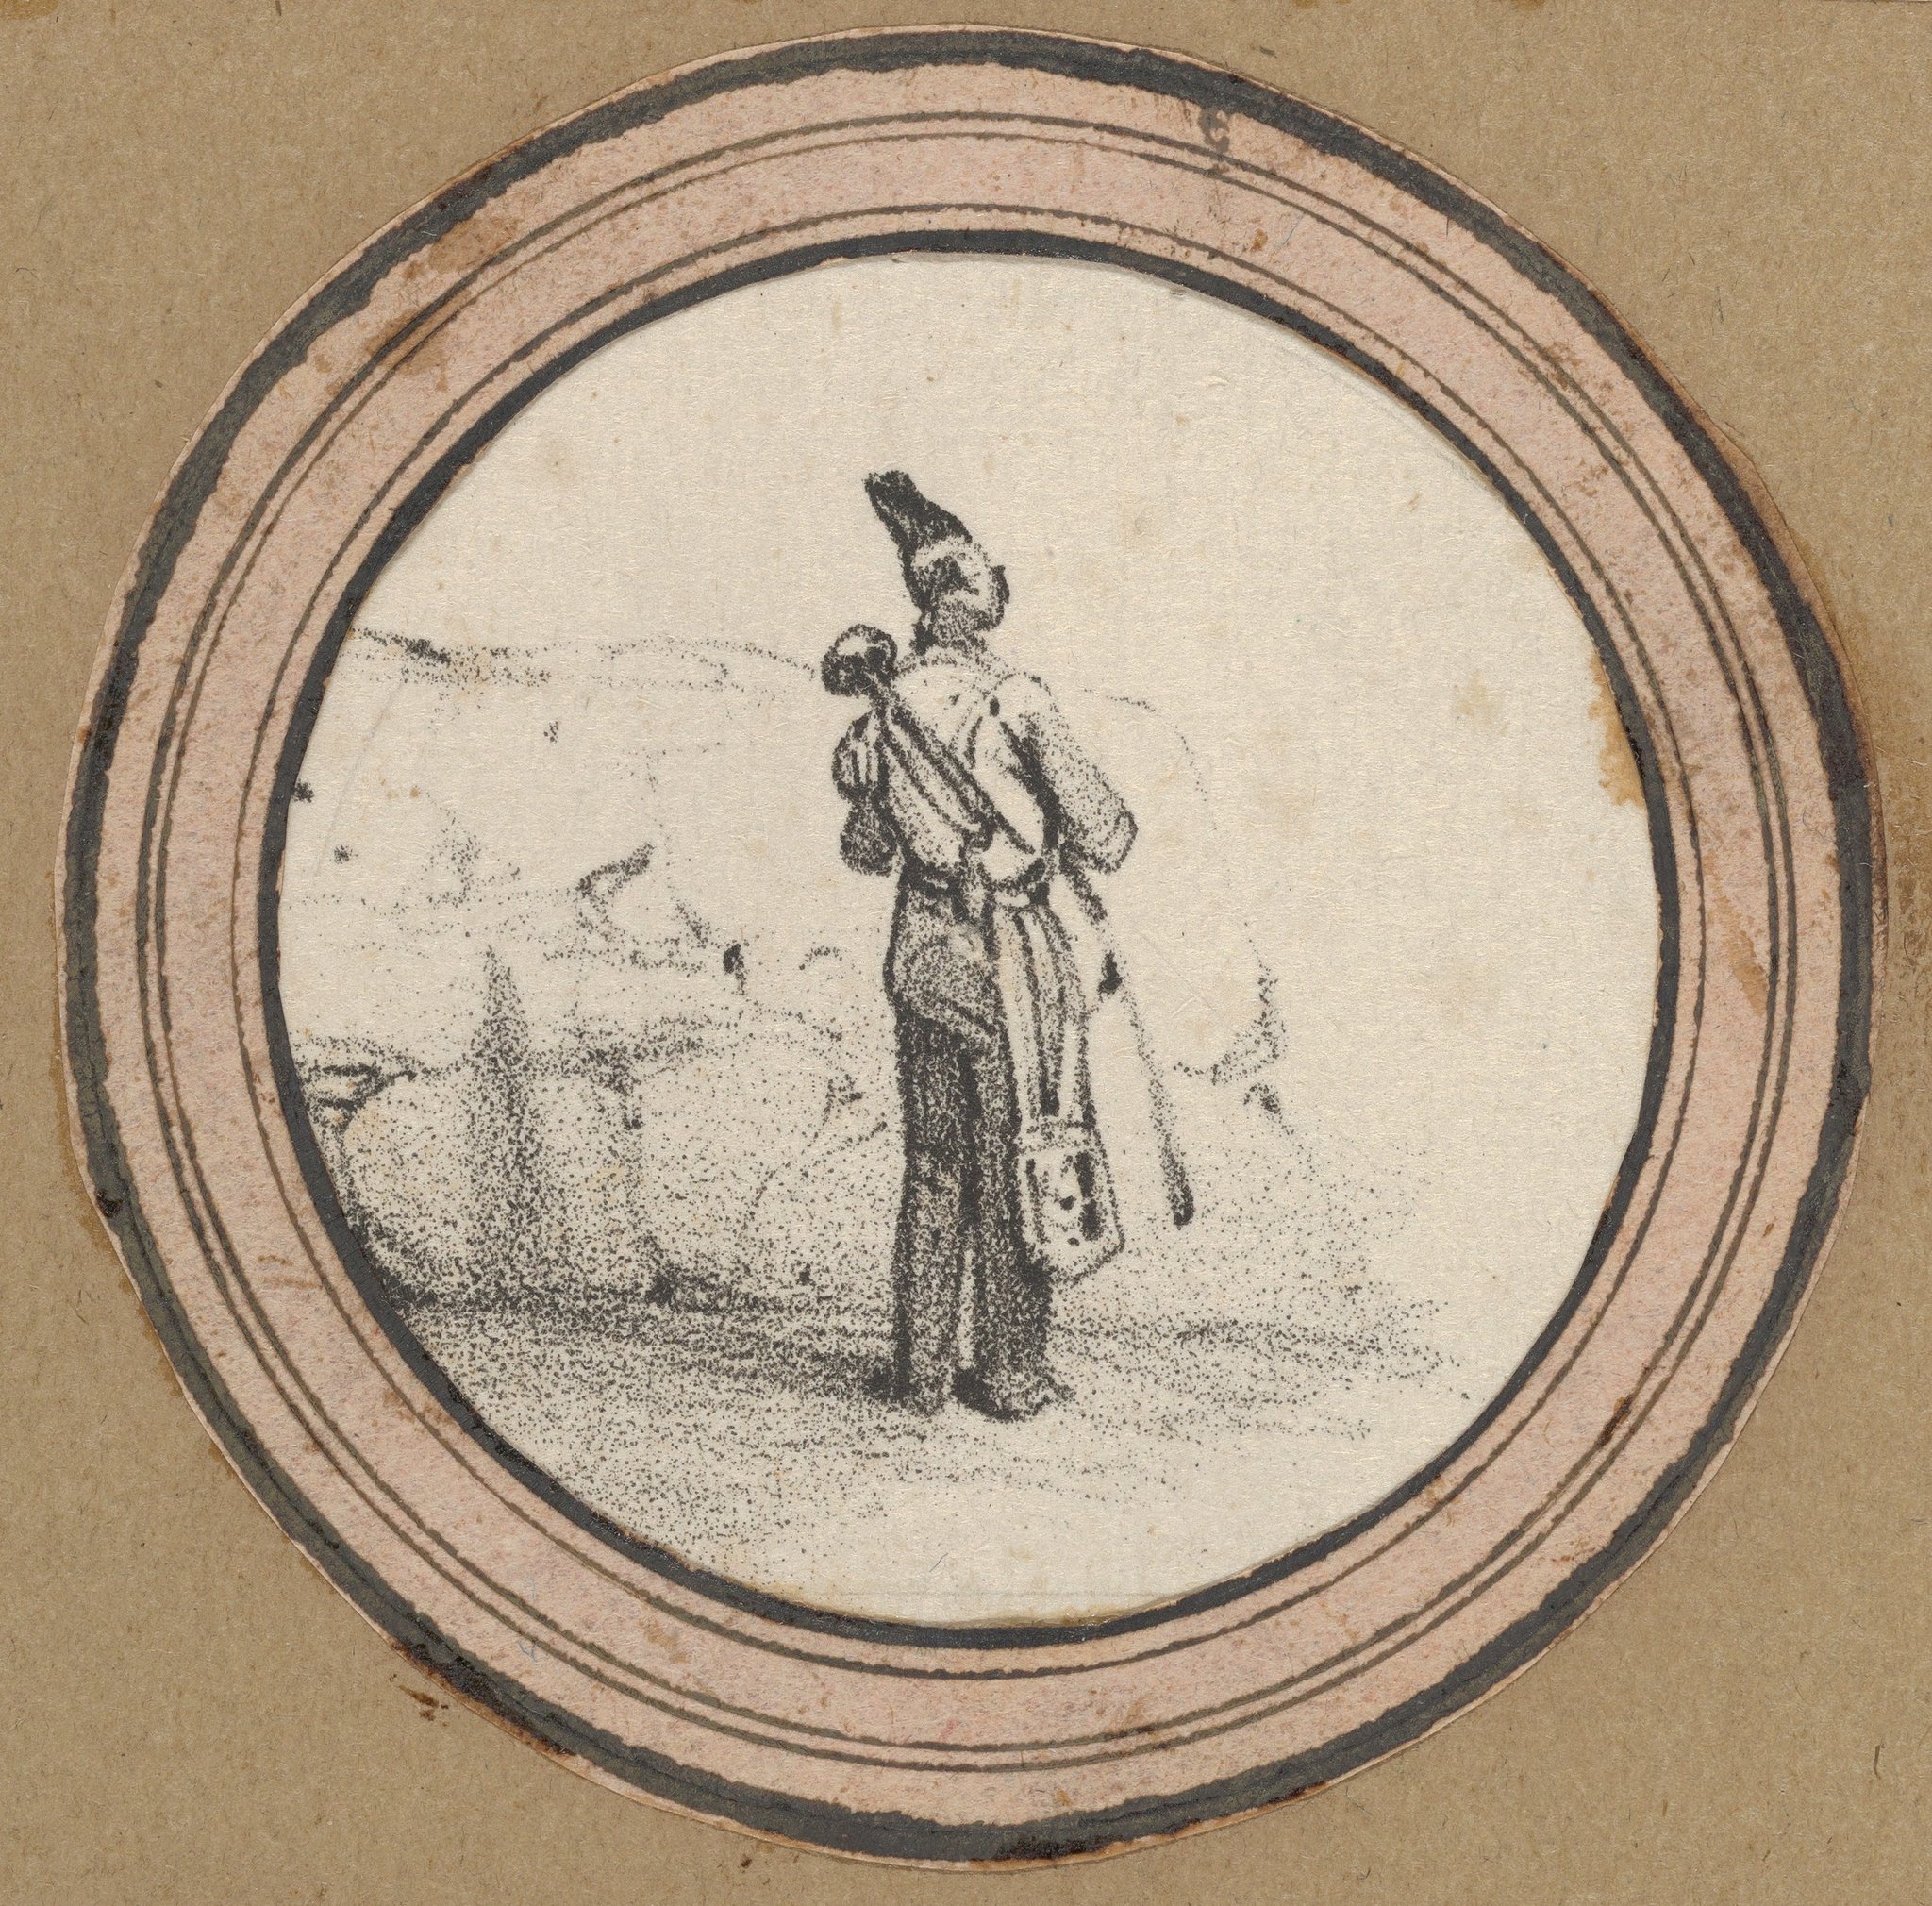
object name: print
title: Standing man, viewed from the back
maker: victor adam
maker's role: artist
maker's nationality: french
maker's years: 1801-1866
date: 1834-1866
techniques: lithograph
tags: men